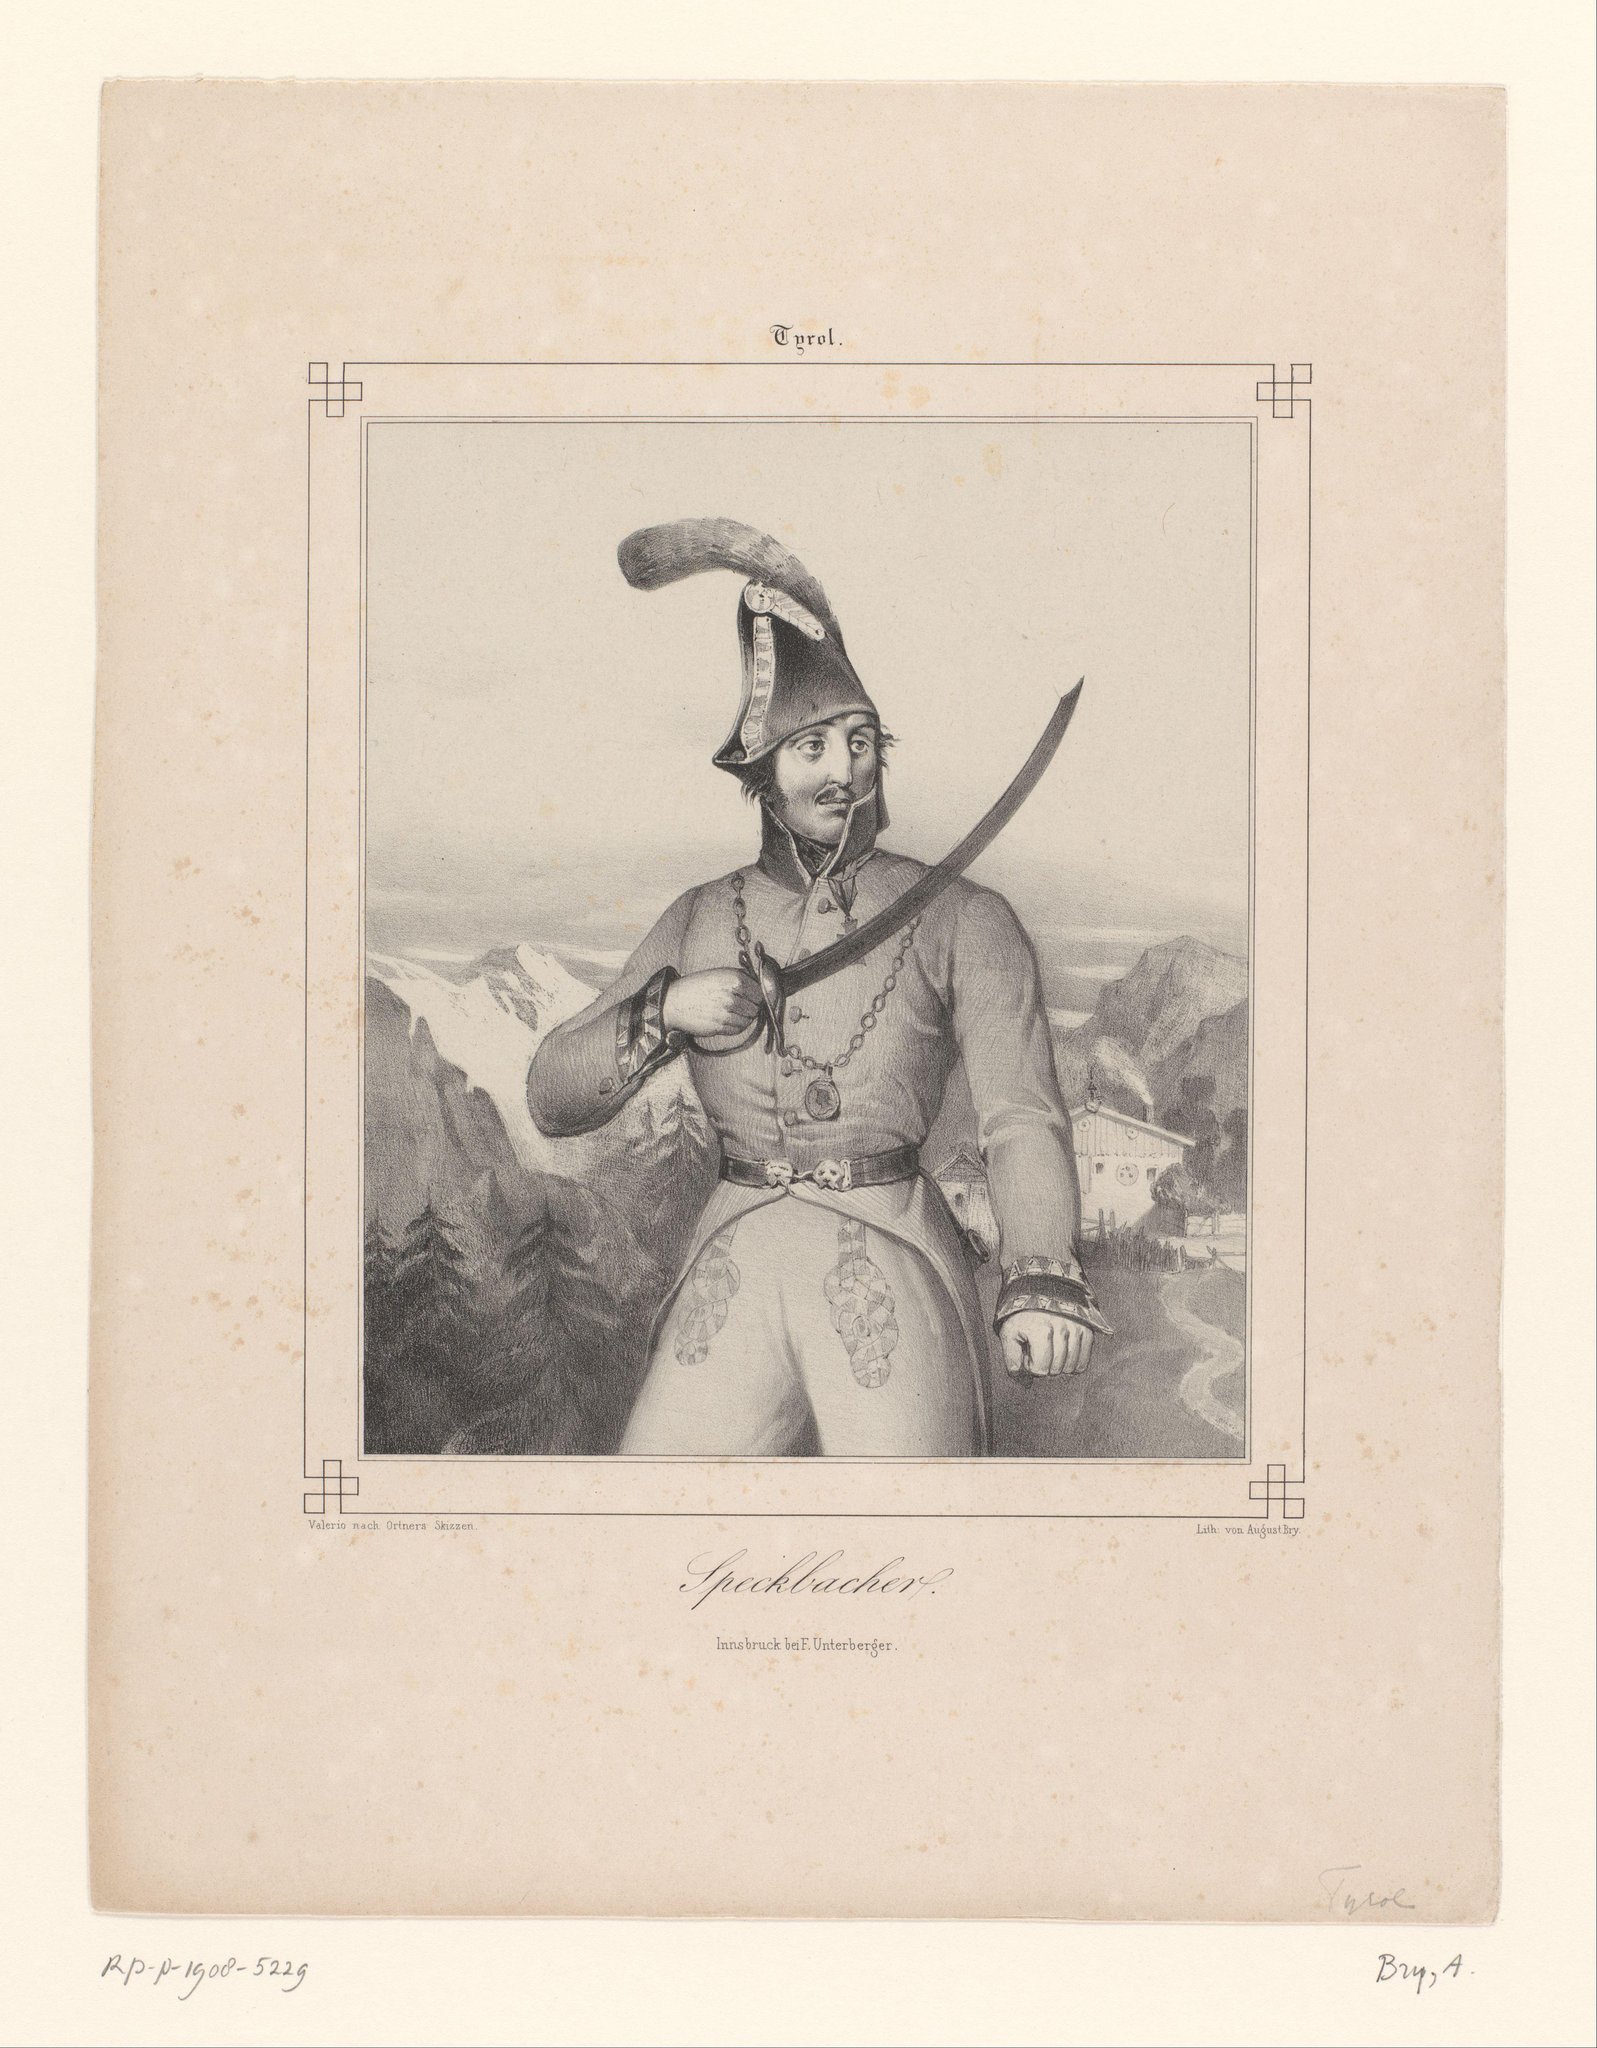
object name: print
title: Portret van de Tiroolse revolutionair Josef Speckbacher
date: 1839-1854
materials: paper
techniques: lithograph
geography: paris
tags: historical persons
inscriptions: collector's mark: Lugt 2228a